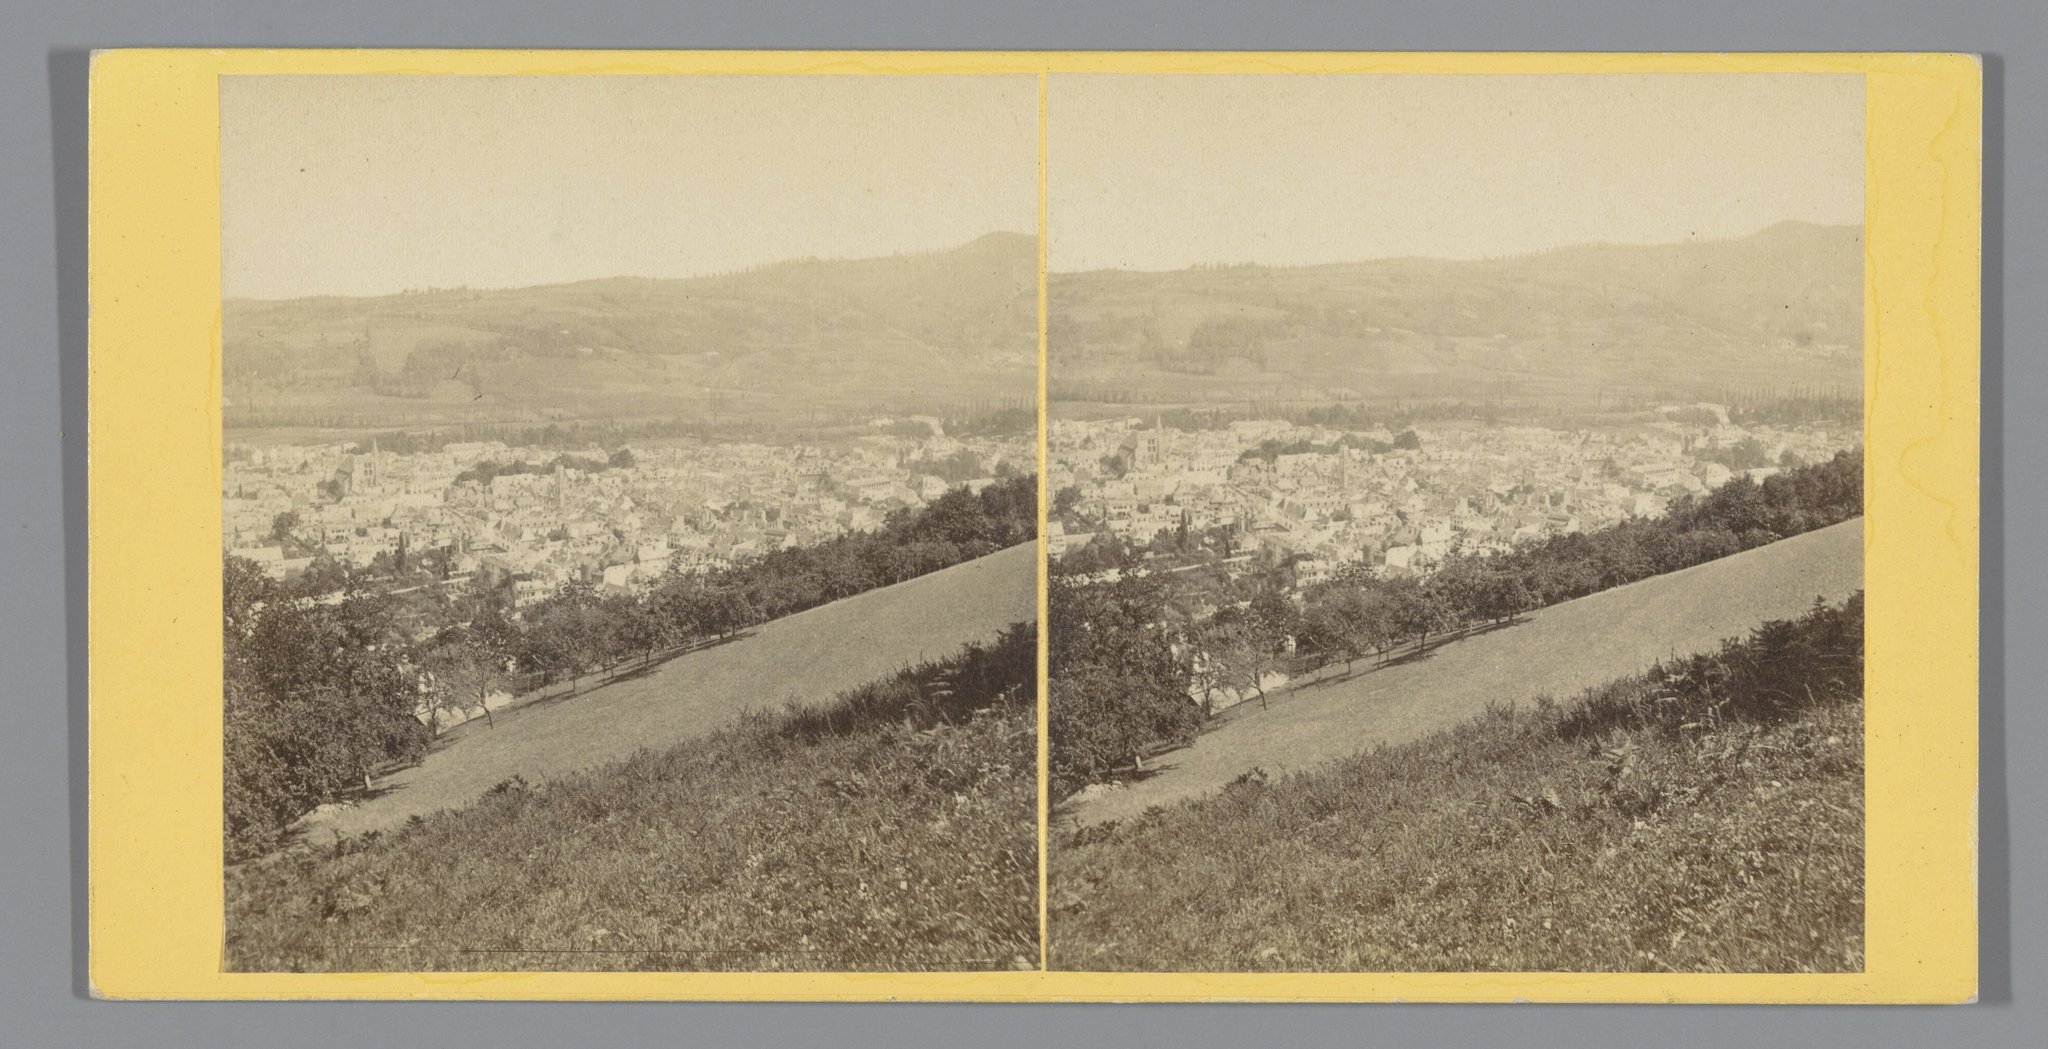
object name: stereograph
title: Vue prise de la Fontaine (Bagnères de Bigorre)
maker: Anonymous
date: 1860-1880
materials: cardboard, photographic support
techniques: albumen print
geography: midi-pyrenees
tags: bagnères-de-bigorre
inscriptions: number: ‘48.’